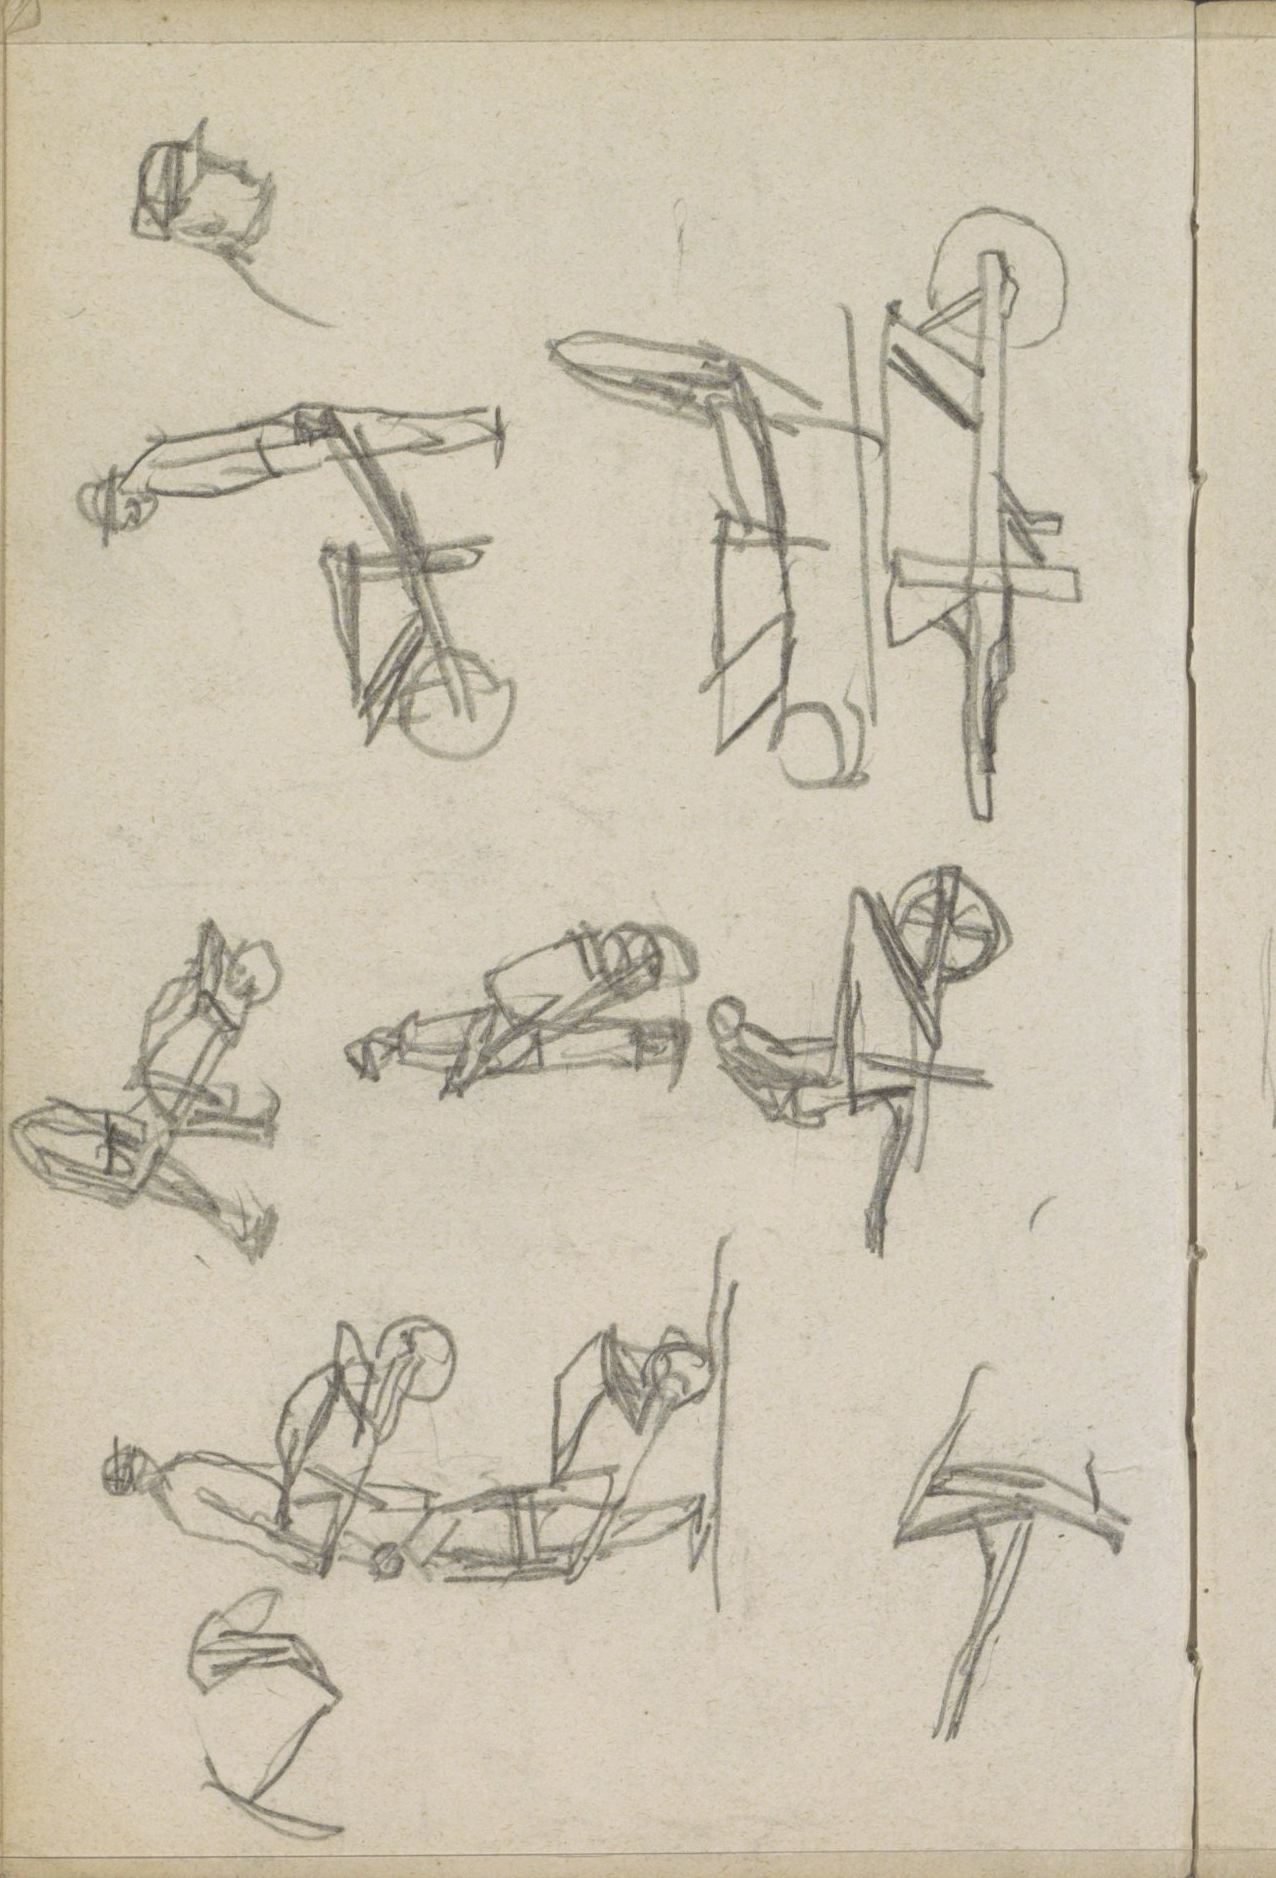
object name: sketchbook leaf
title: Studieblad met kruiwagens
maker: george hendrik breitner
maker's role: draughtsman, painter, print maker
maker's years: 1857-1923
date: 1902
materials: paper, pencil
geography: amsterdam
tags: hand-cart, adult man, wheelbarrow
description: Sommige handkarren worden door een man vastgehouden. Pagina 73 uit een schetsboek met 46 bladen vervaardigd in de omgeving van Amsterdam, Rotterdam en Haarlem.